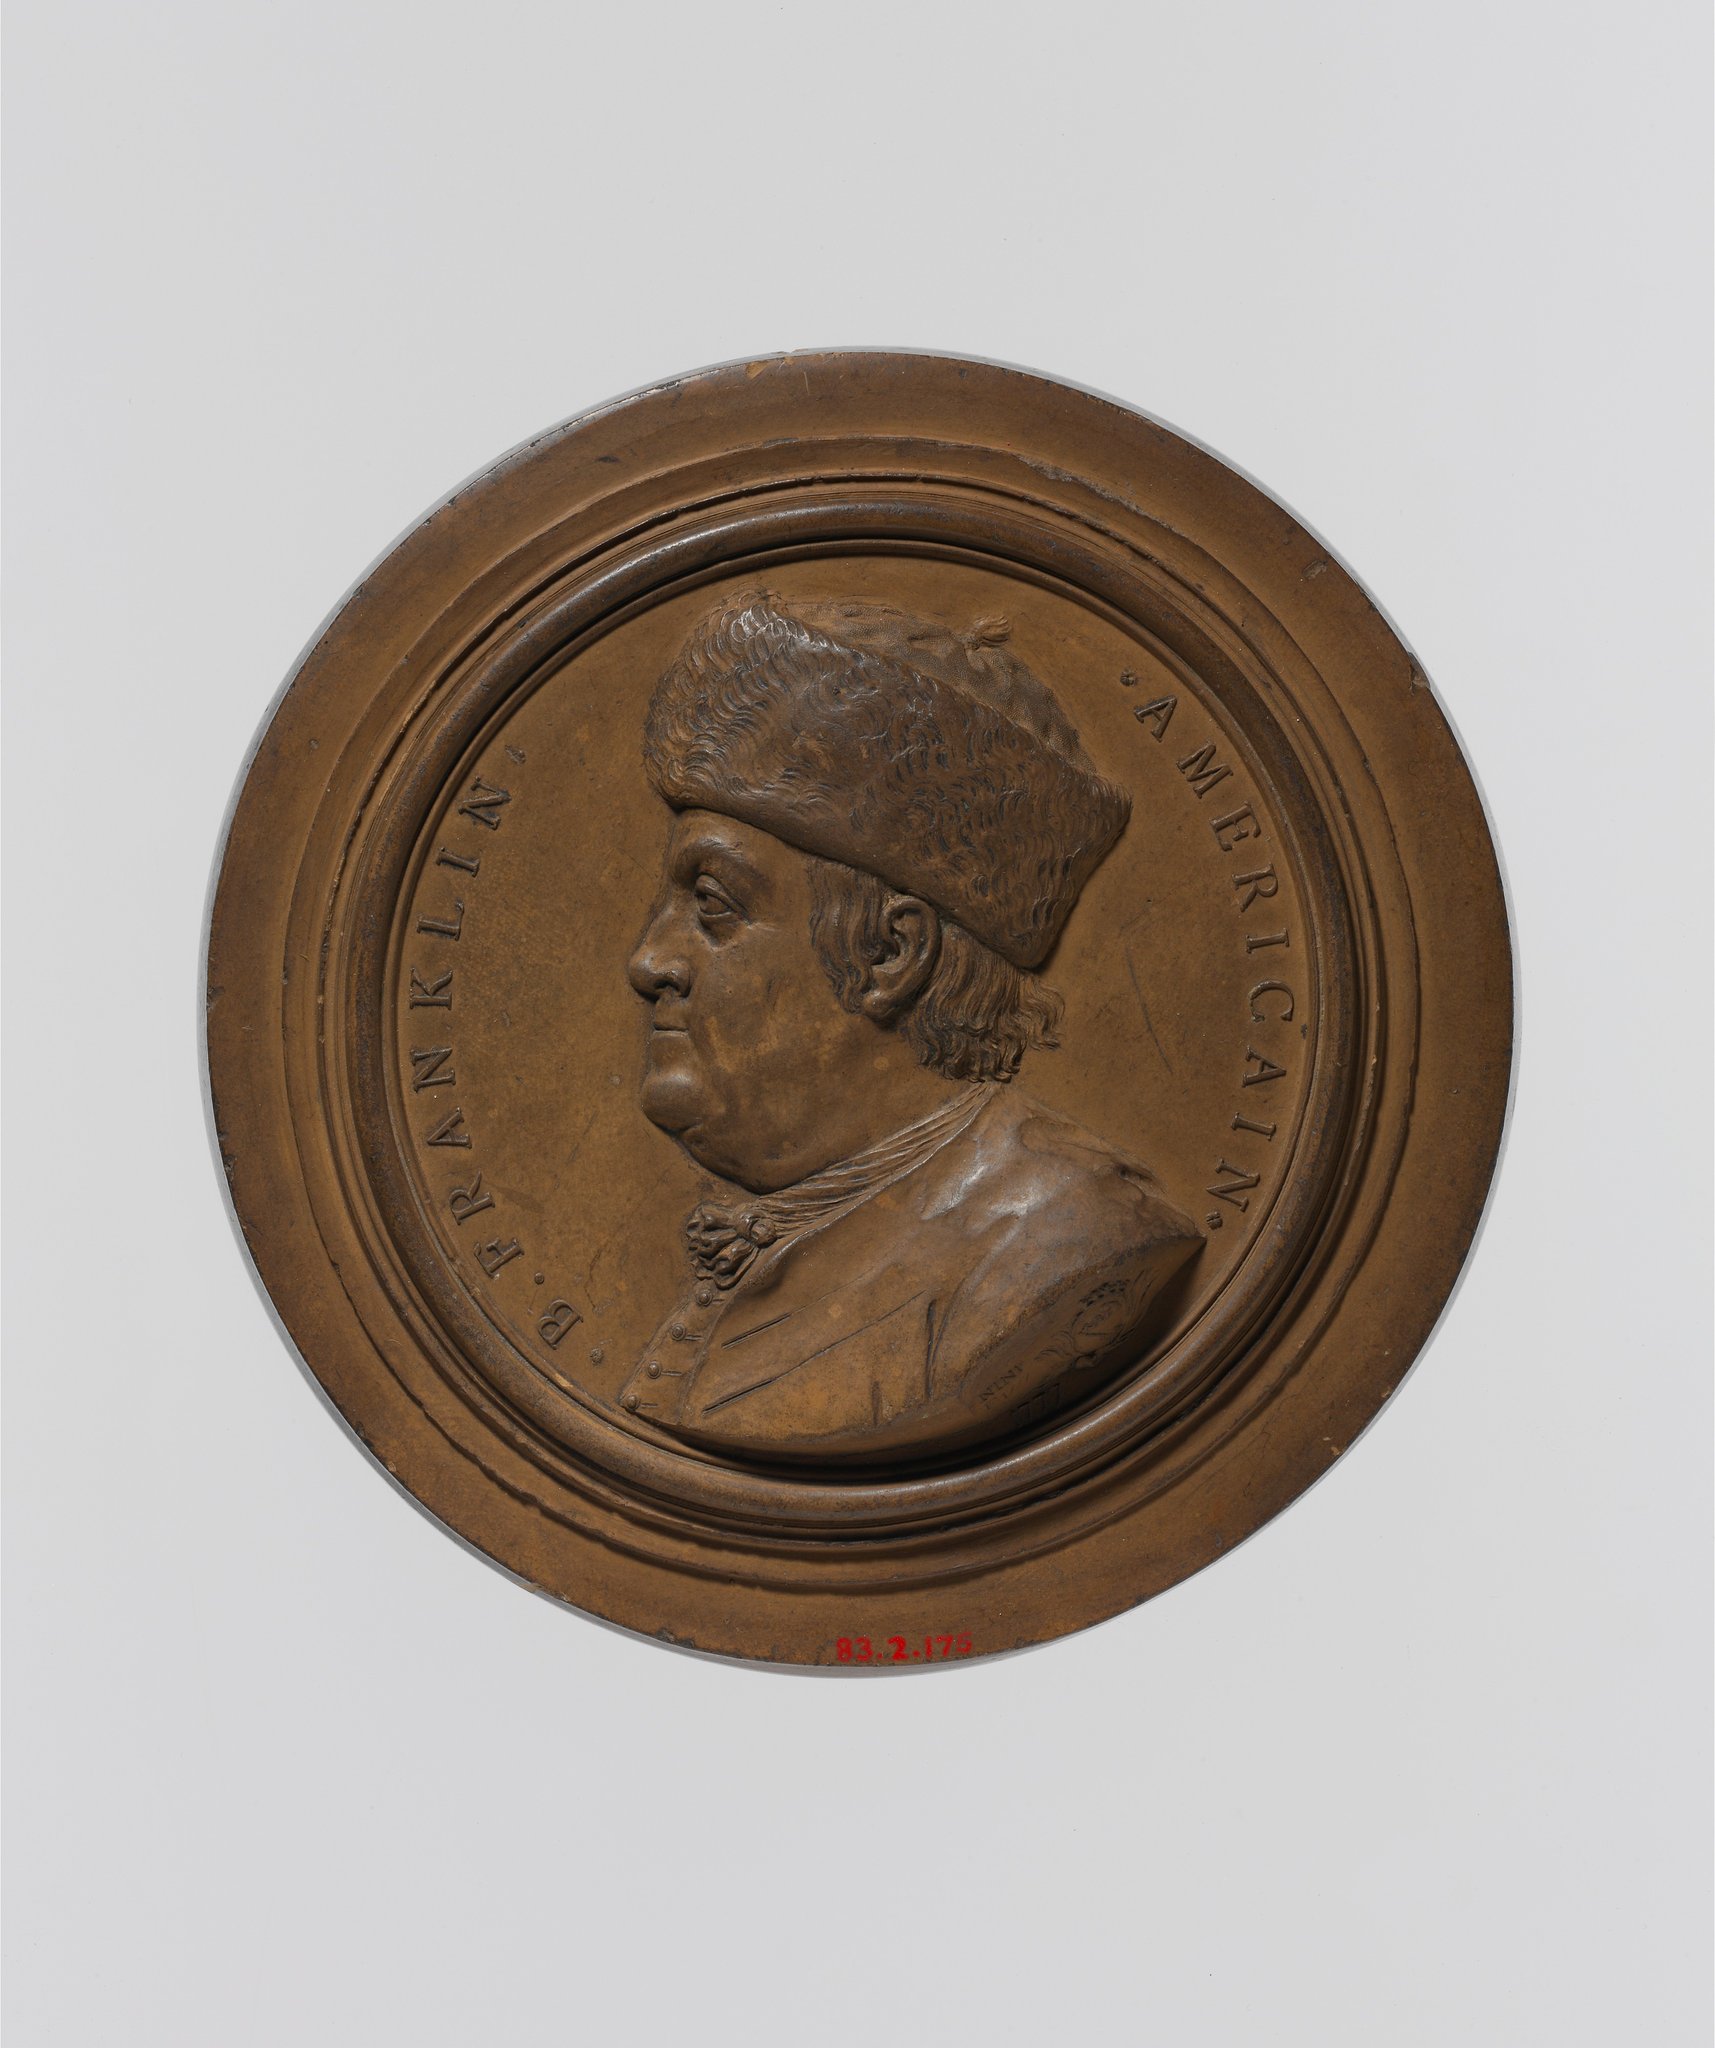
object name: medallion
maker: jean-baptiste nini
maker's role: maker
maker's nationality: italian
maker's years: 1717-1786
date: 1777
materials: terracotta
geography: france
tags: benjamin franklin,men,profiles